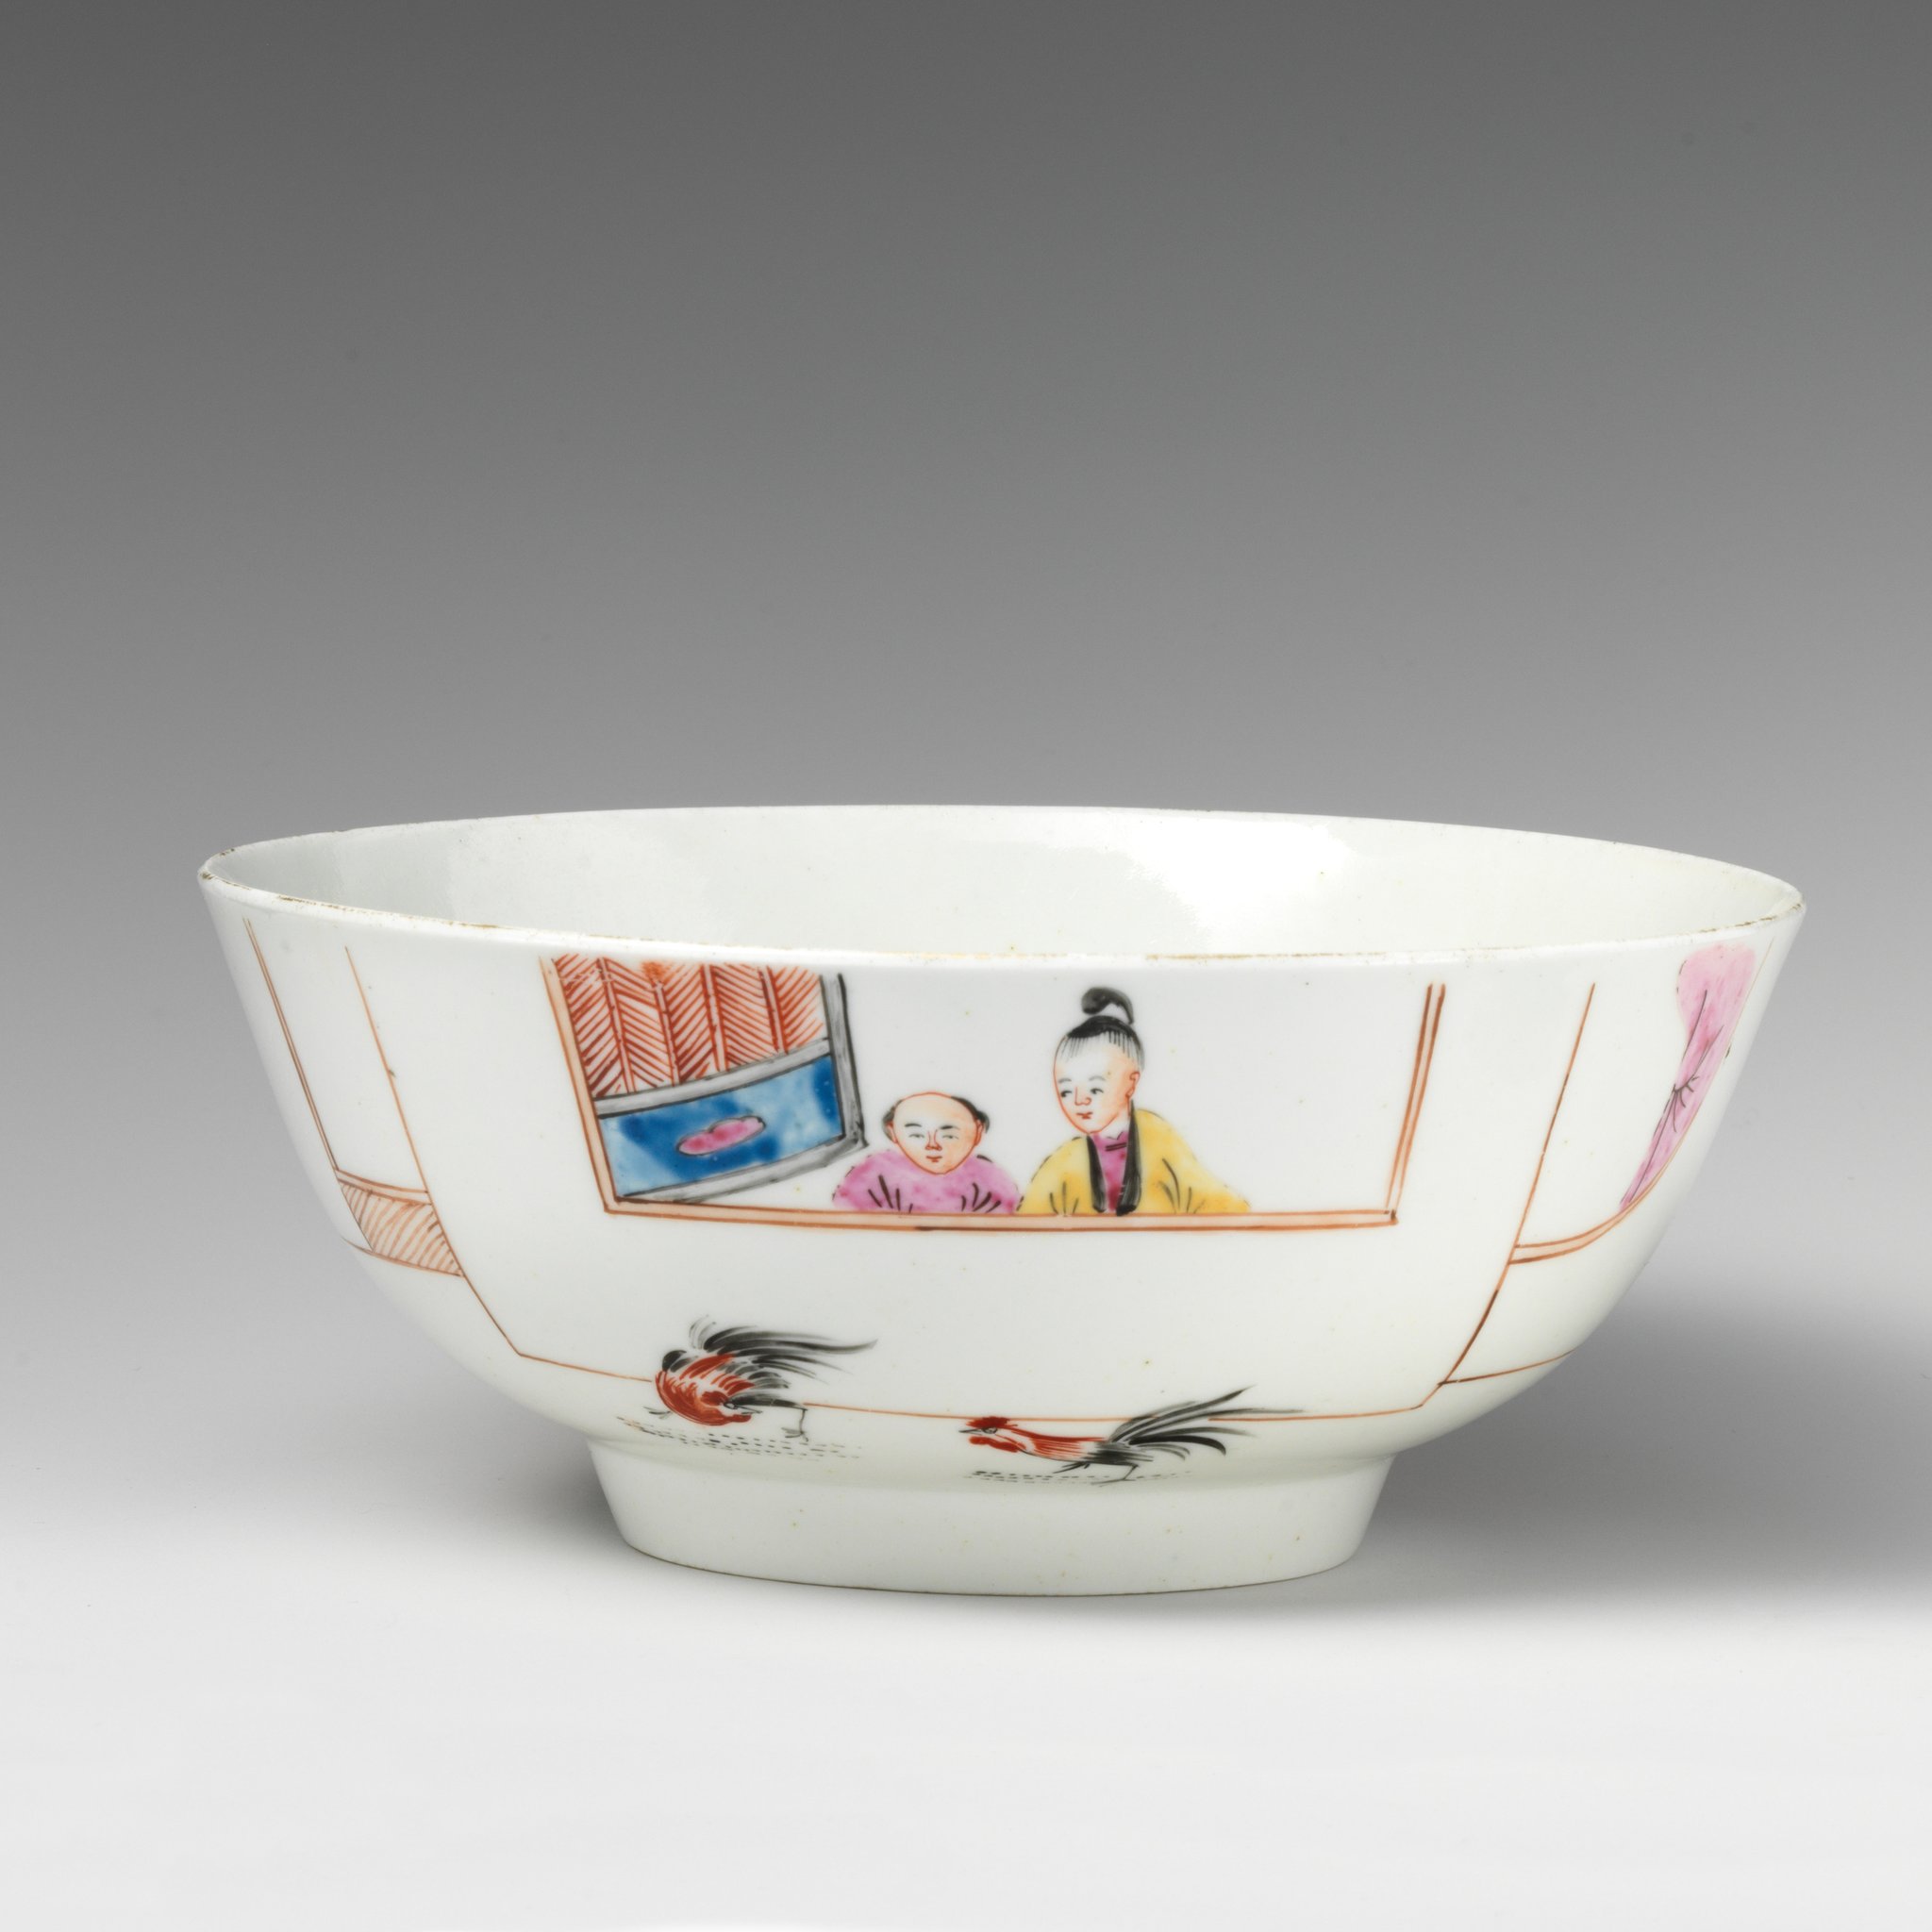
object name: bowl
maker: worcester factory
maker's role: factory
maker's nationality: british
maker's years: 1751-2008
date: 1701-1800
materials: soft paste porcelain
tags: roosters